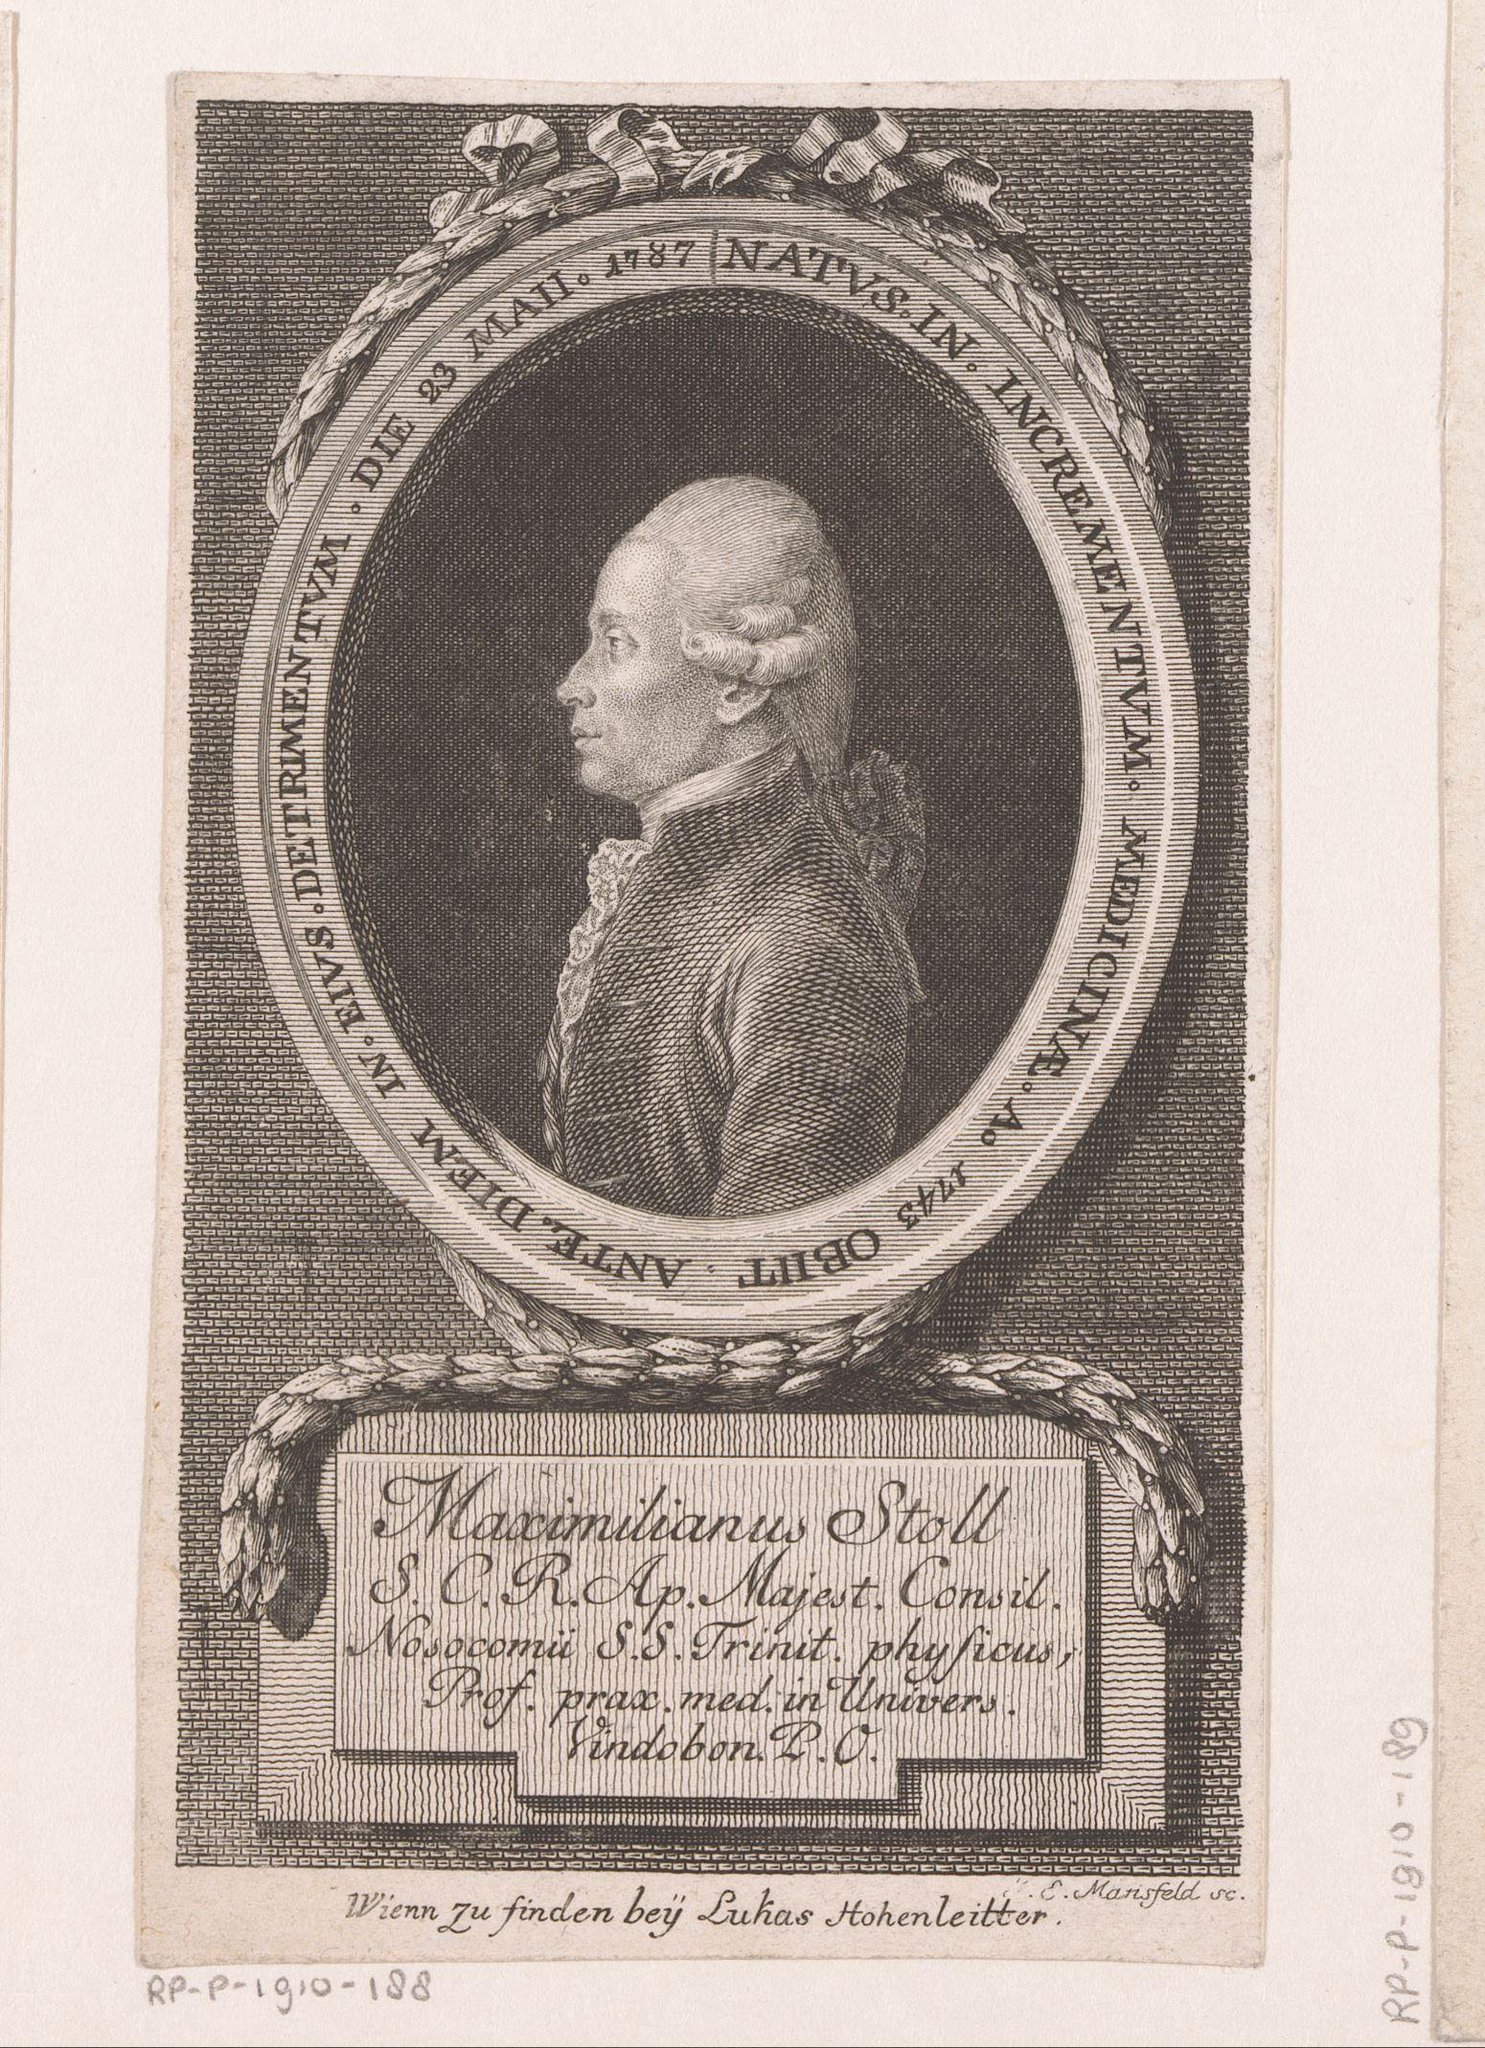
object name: print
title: Portret van Maximilian Stoll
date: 1778-1796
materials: paper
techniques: engraving, etching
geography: vienna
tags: vienna, historical persons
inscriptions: collector's mark: Lugt 2228